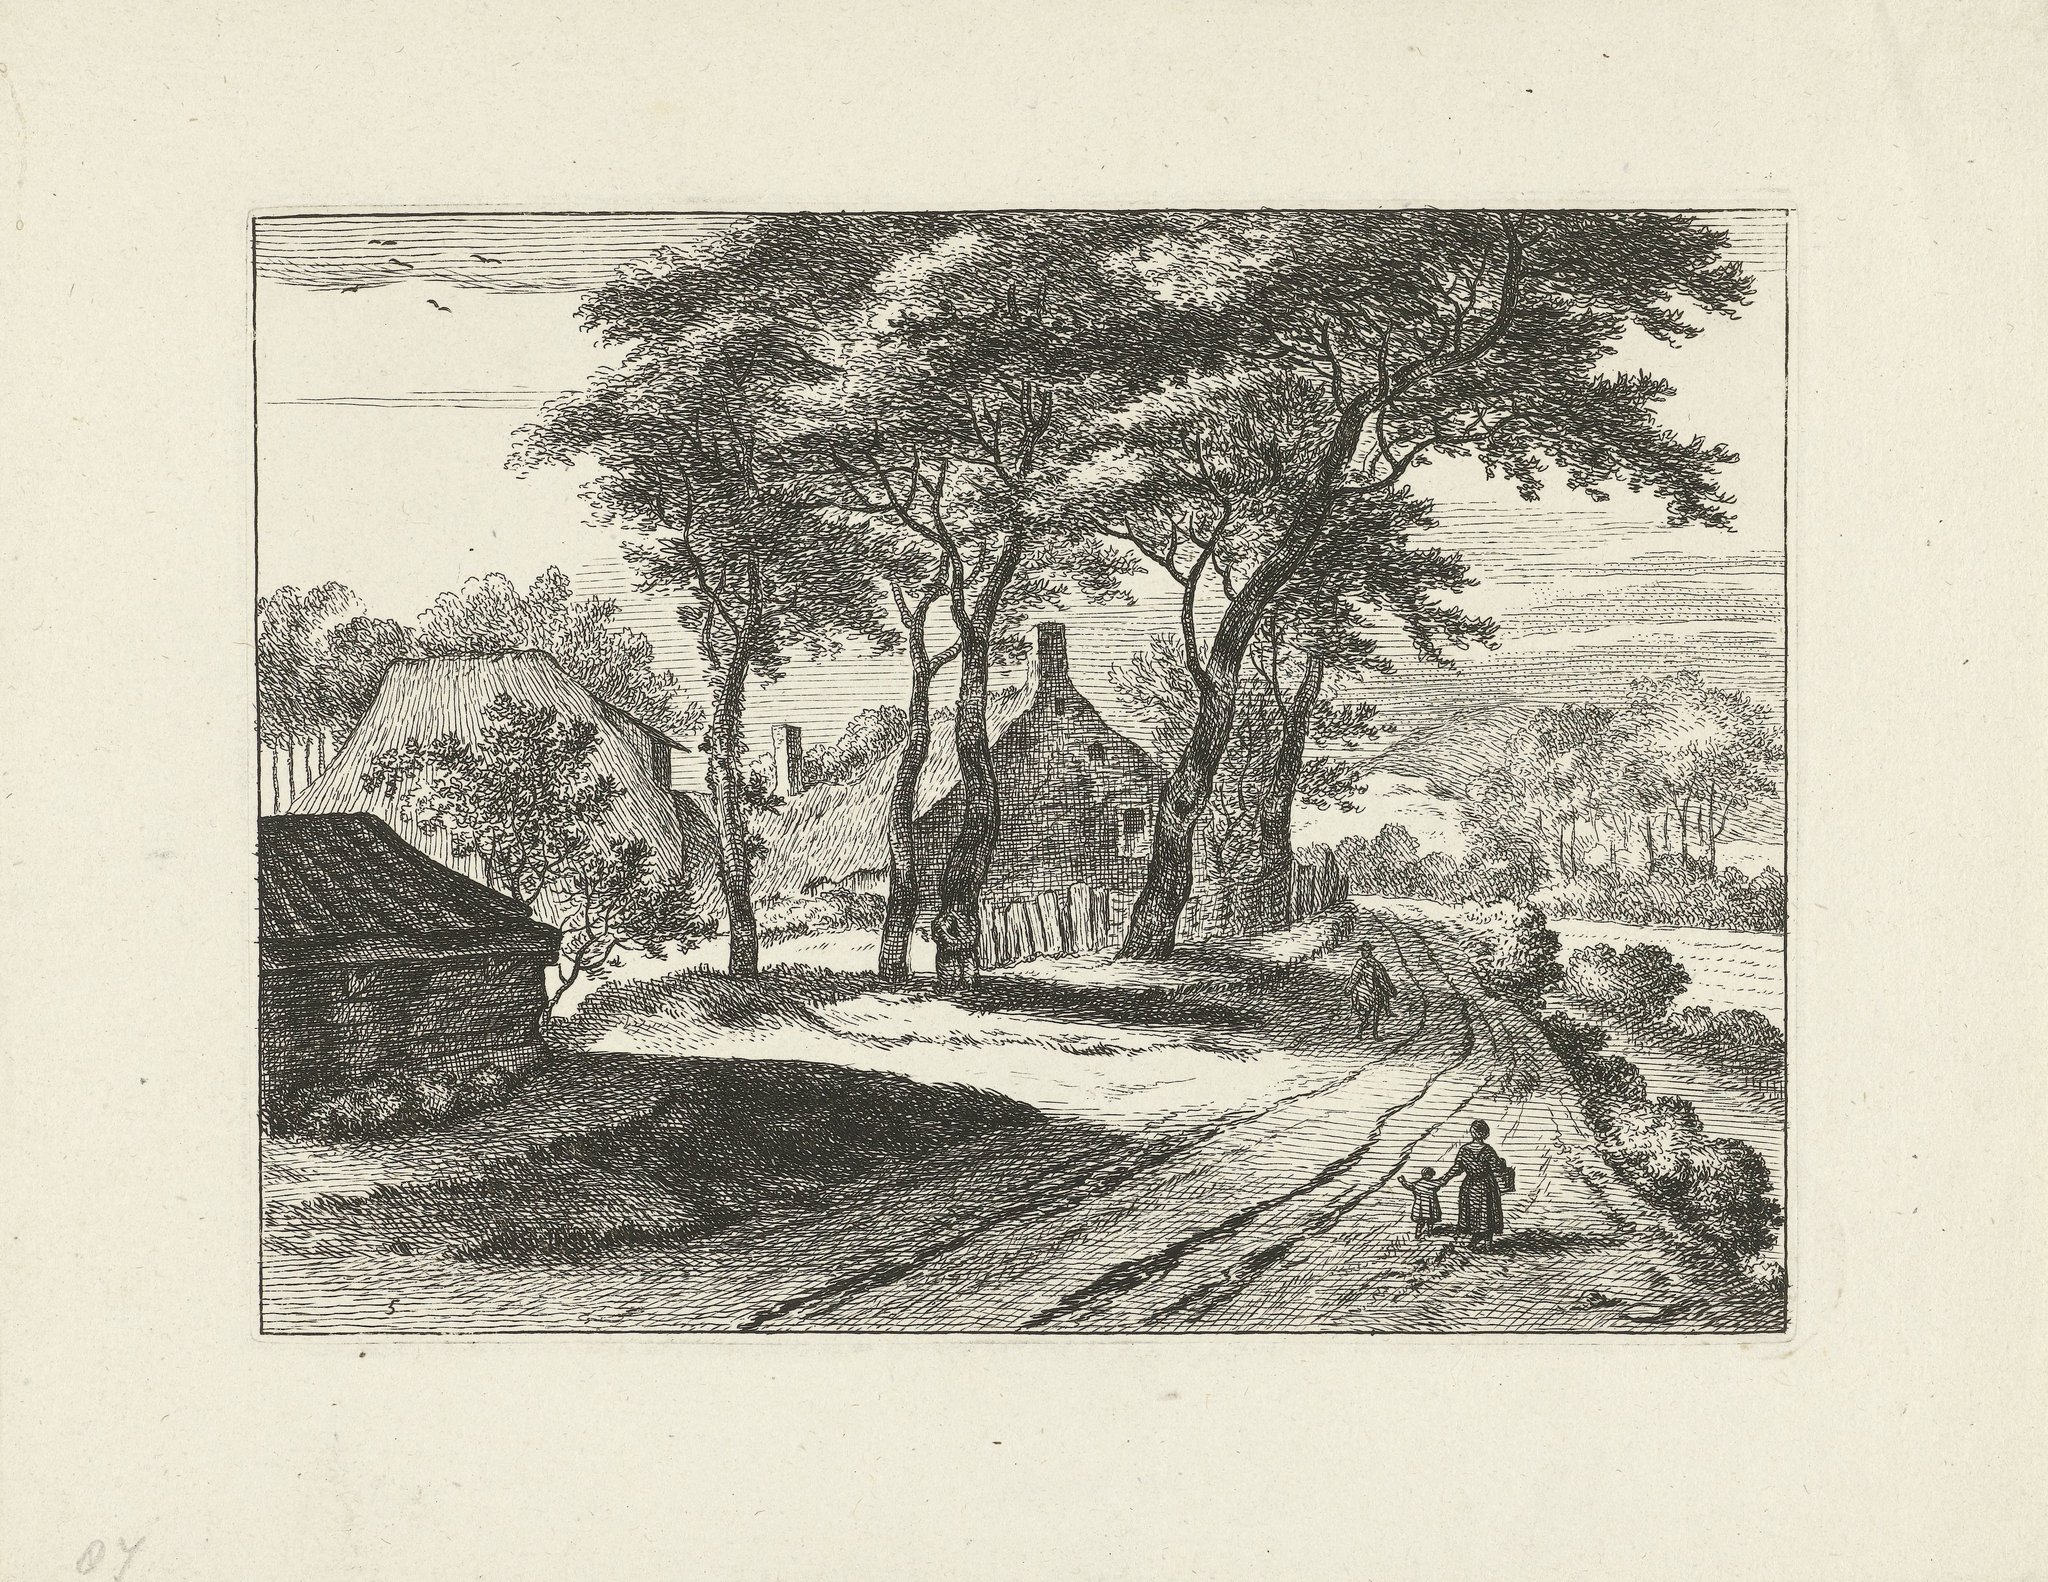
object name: print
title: Landschappen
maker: johannes gronsveld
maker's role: draughtsman, painter, print maker, publisher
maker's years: 1658-1728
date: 1679-1728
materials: paper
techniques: engraving, etching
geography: amsterdam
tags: mother and baby or young child, landscapes (+ landscape with figures, staffage)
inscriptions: collector's mark: Lugt 240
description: Boslandschap met boerderij. Rechtsvoor een landweg met moeder en kind. Een man ruiter komt hen tegemoet. Vijfde prent uit een serie van zes met landschappen.